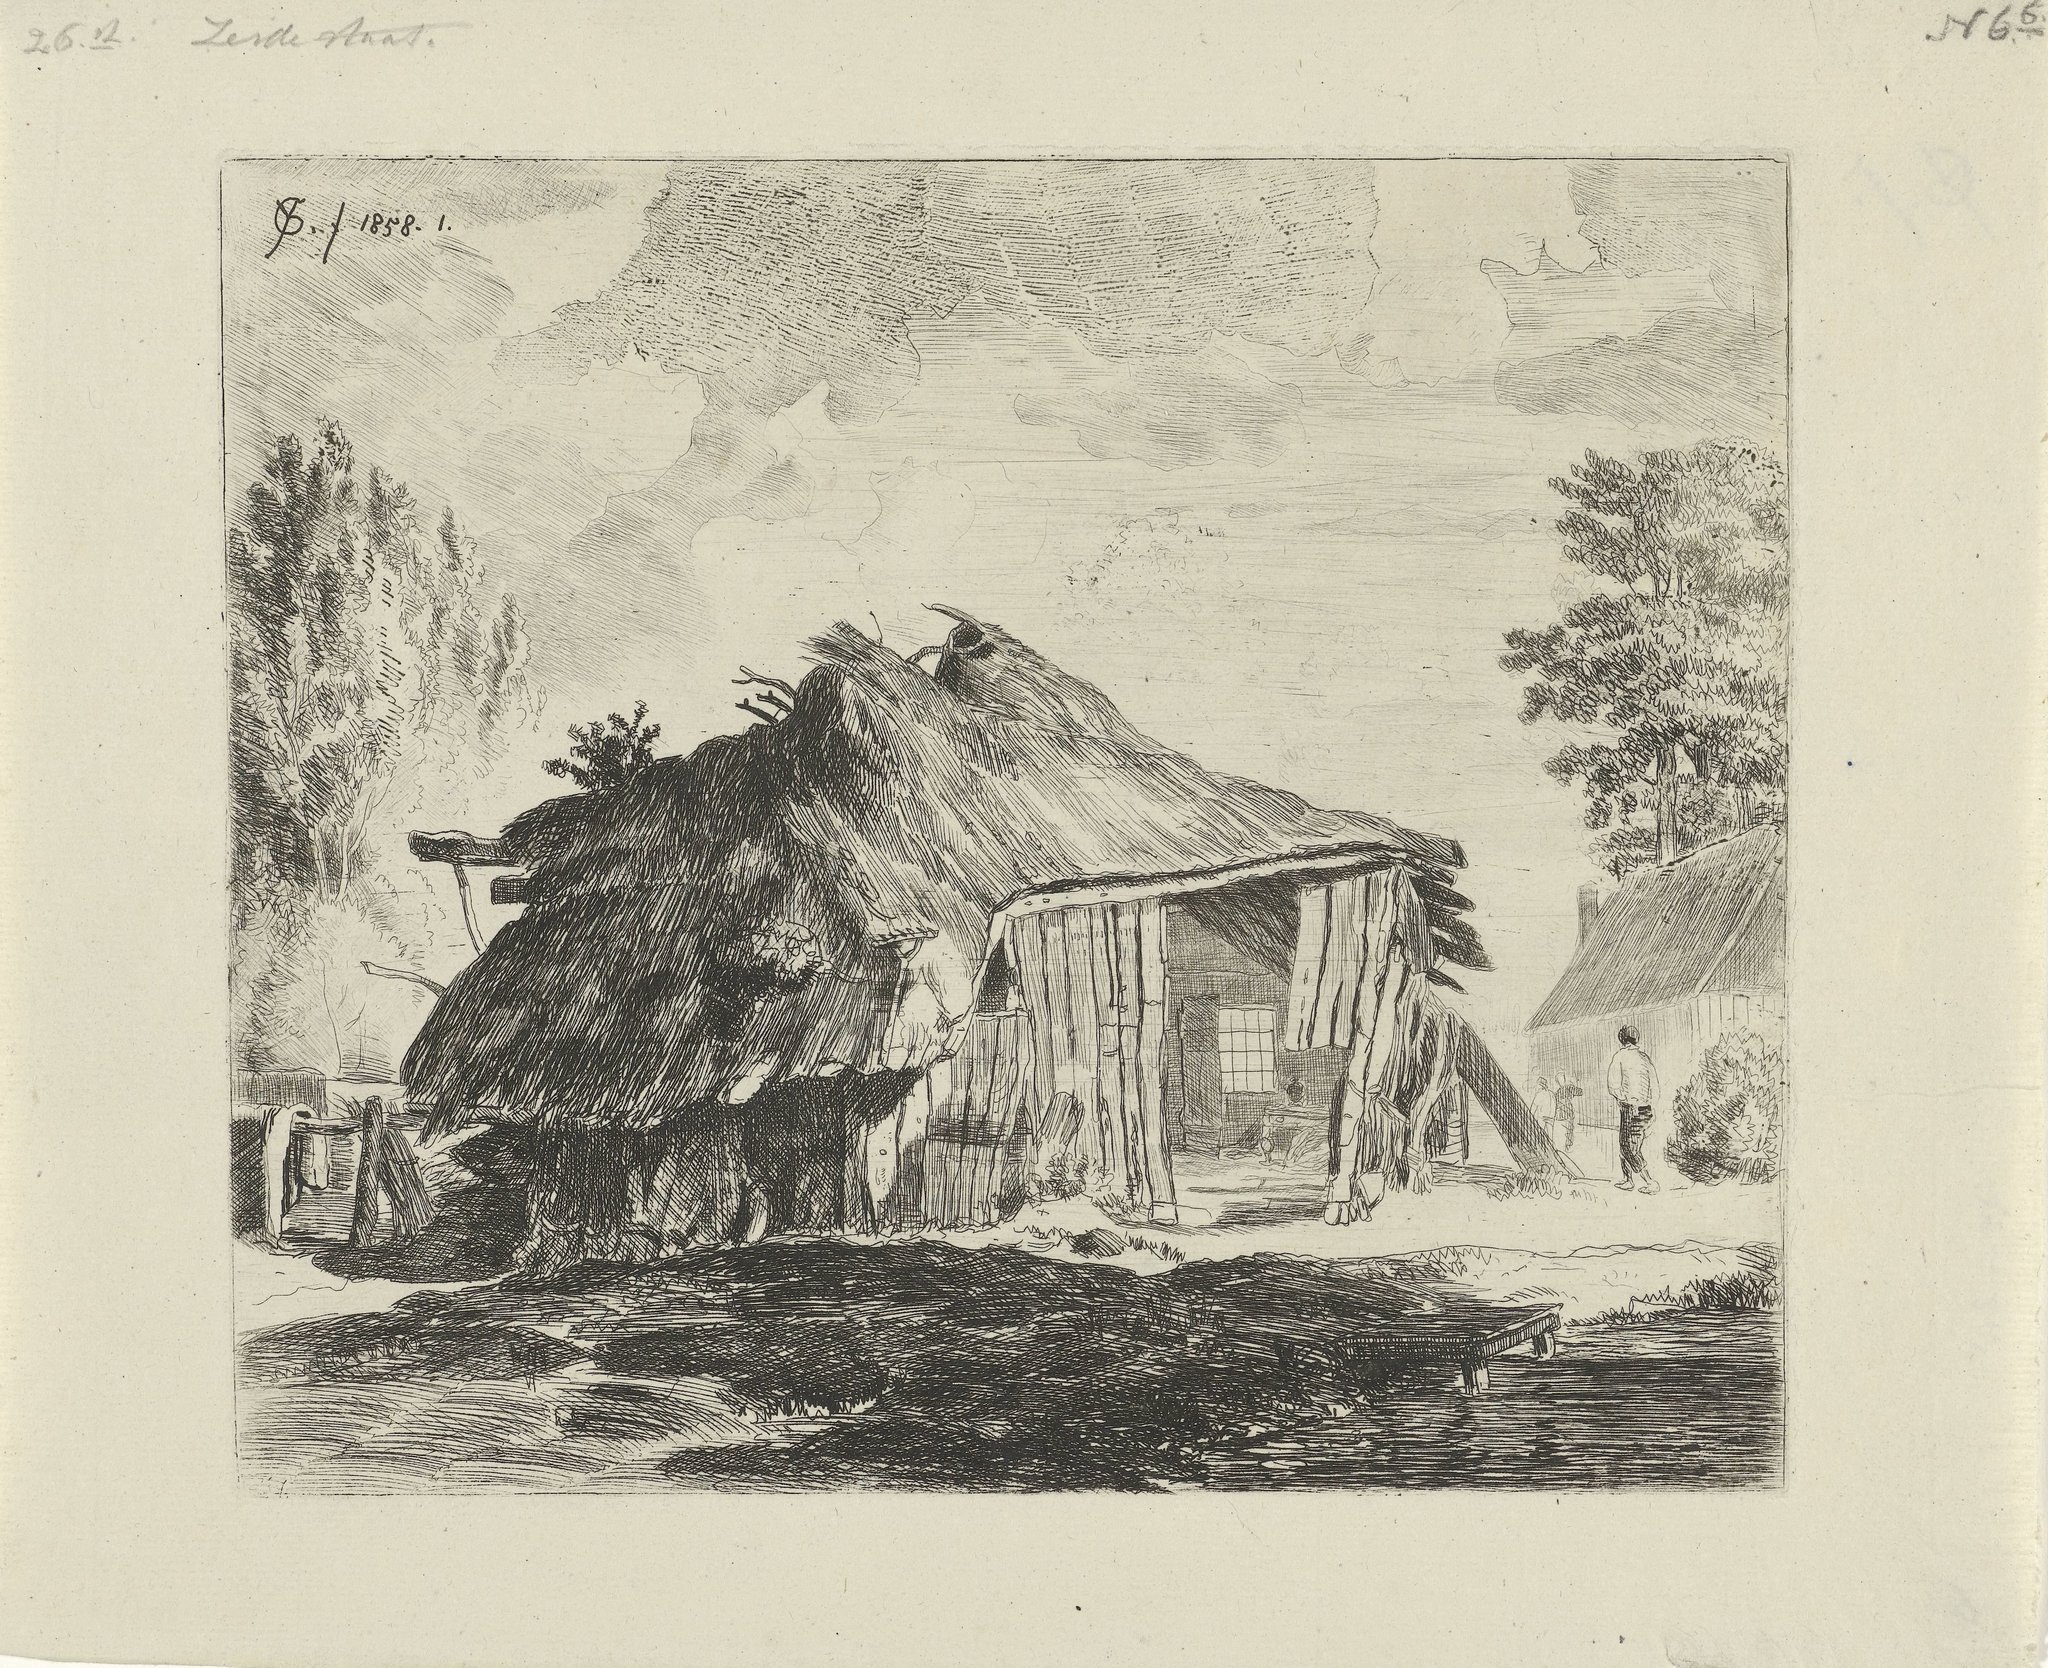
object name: print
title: Schuur in een landschap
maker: cornelis van der griendt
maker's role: draughtsman, painter, print maker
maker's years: 1827-1918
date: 1858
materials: paper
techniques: drypoint, etching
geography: netherlands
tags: barn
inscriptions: collector's mark: Lugt 2228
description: Schuur in een landschap aan water gelegen. Aan de rechterzijde drie figuren.